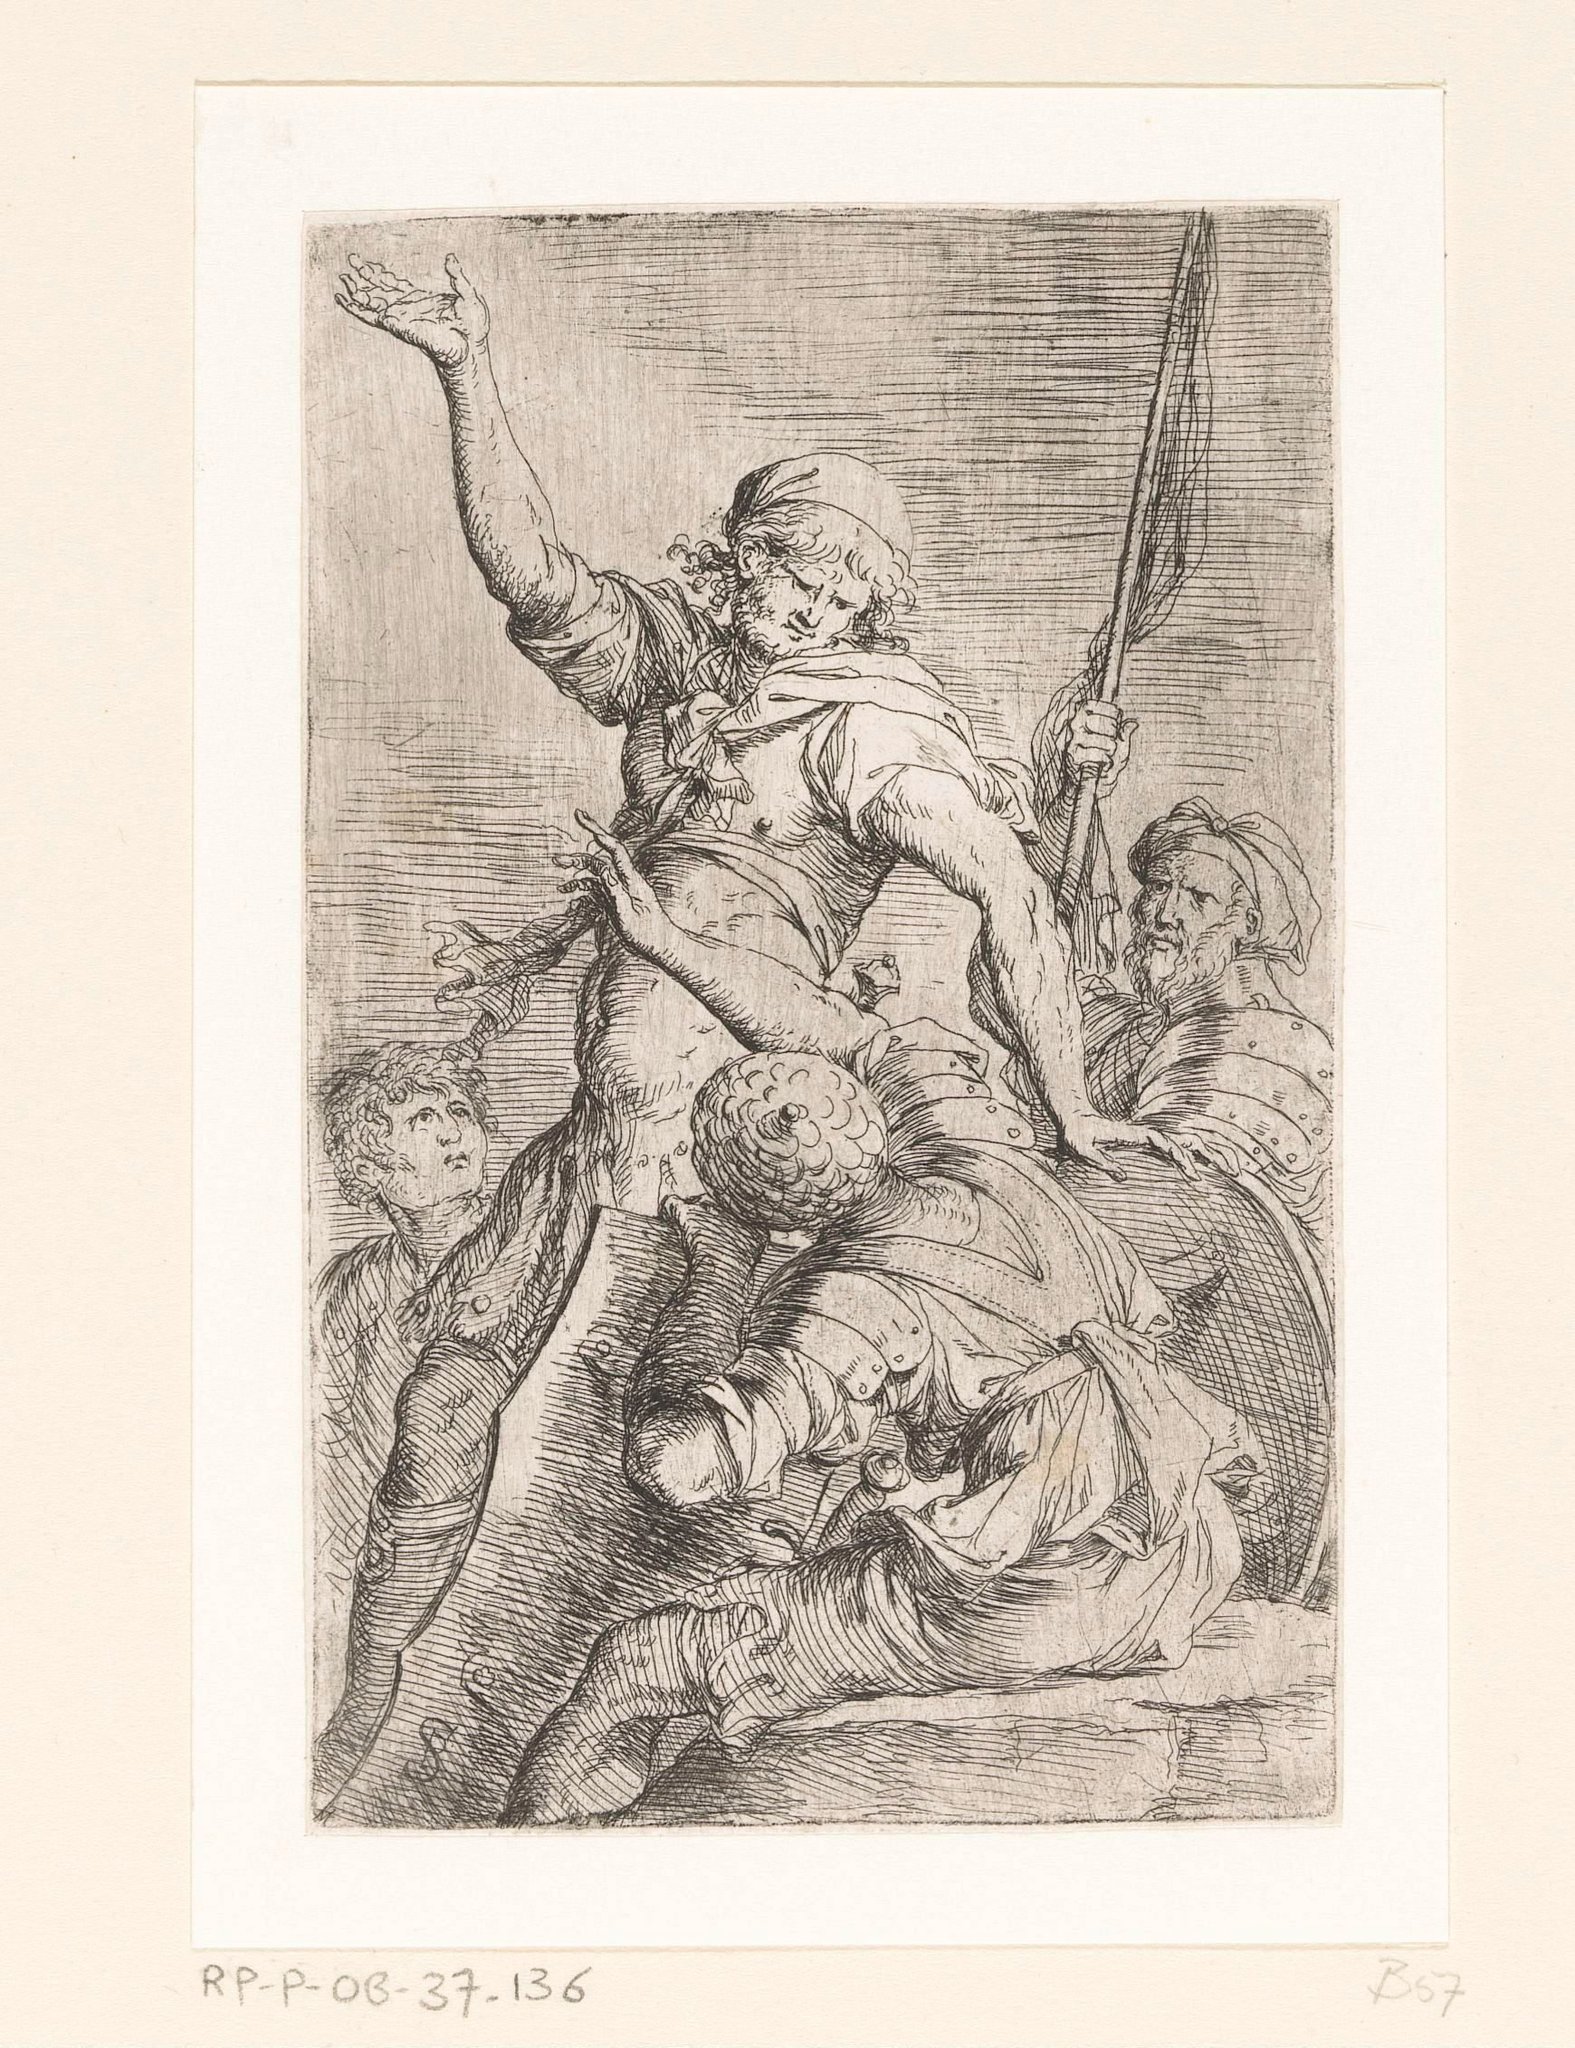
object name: print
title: Kleine figuren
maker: salvator rosa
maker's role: draughtsman, painter, print maker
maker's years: 1615-1673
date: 1656-1657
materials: paper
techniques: drypoint, etching, intaglio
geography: italy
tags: the soldier; the soldier's life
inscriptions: number: ‘30’, collector's mark: Lugt 240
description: Deze prent maakt deel uit van de serie 'Figurine', bestaande uit een titelprent en 80 prenten van klein formaat met voorstellingen van mannelijke en vrouwelijke figuren. Rosa produceerde de serie waarschijnlijk gedurende de jaren 1656 en 1657.